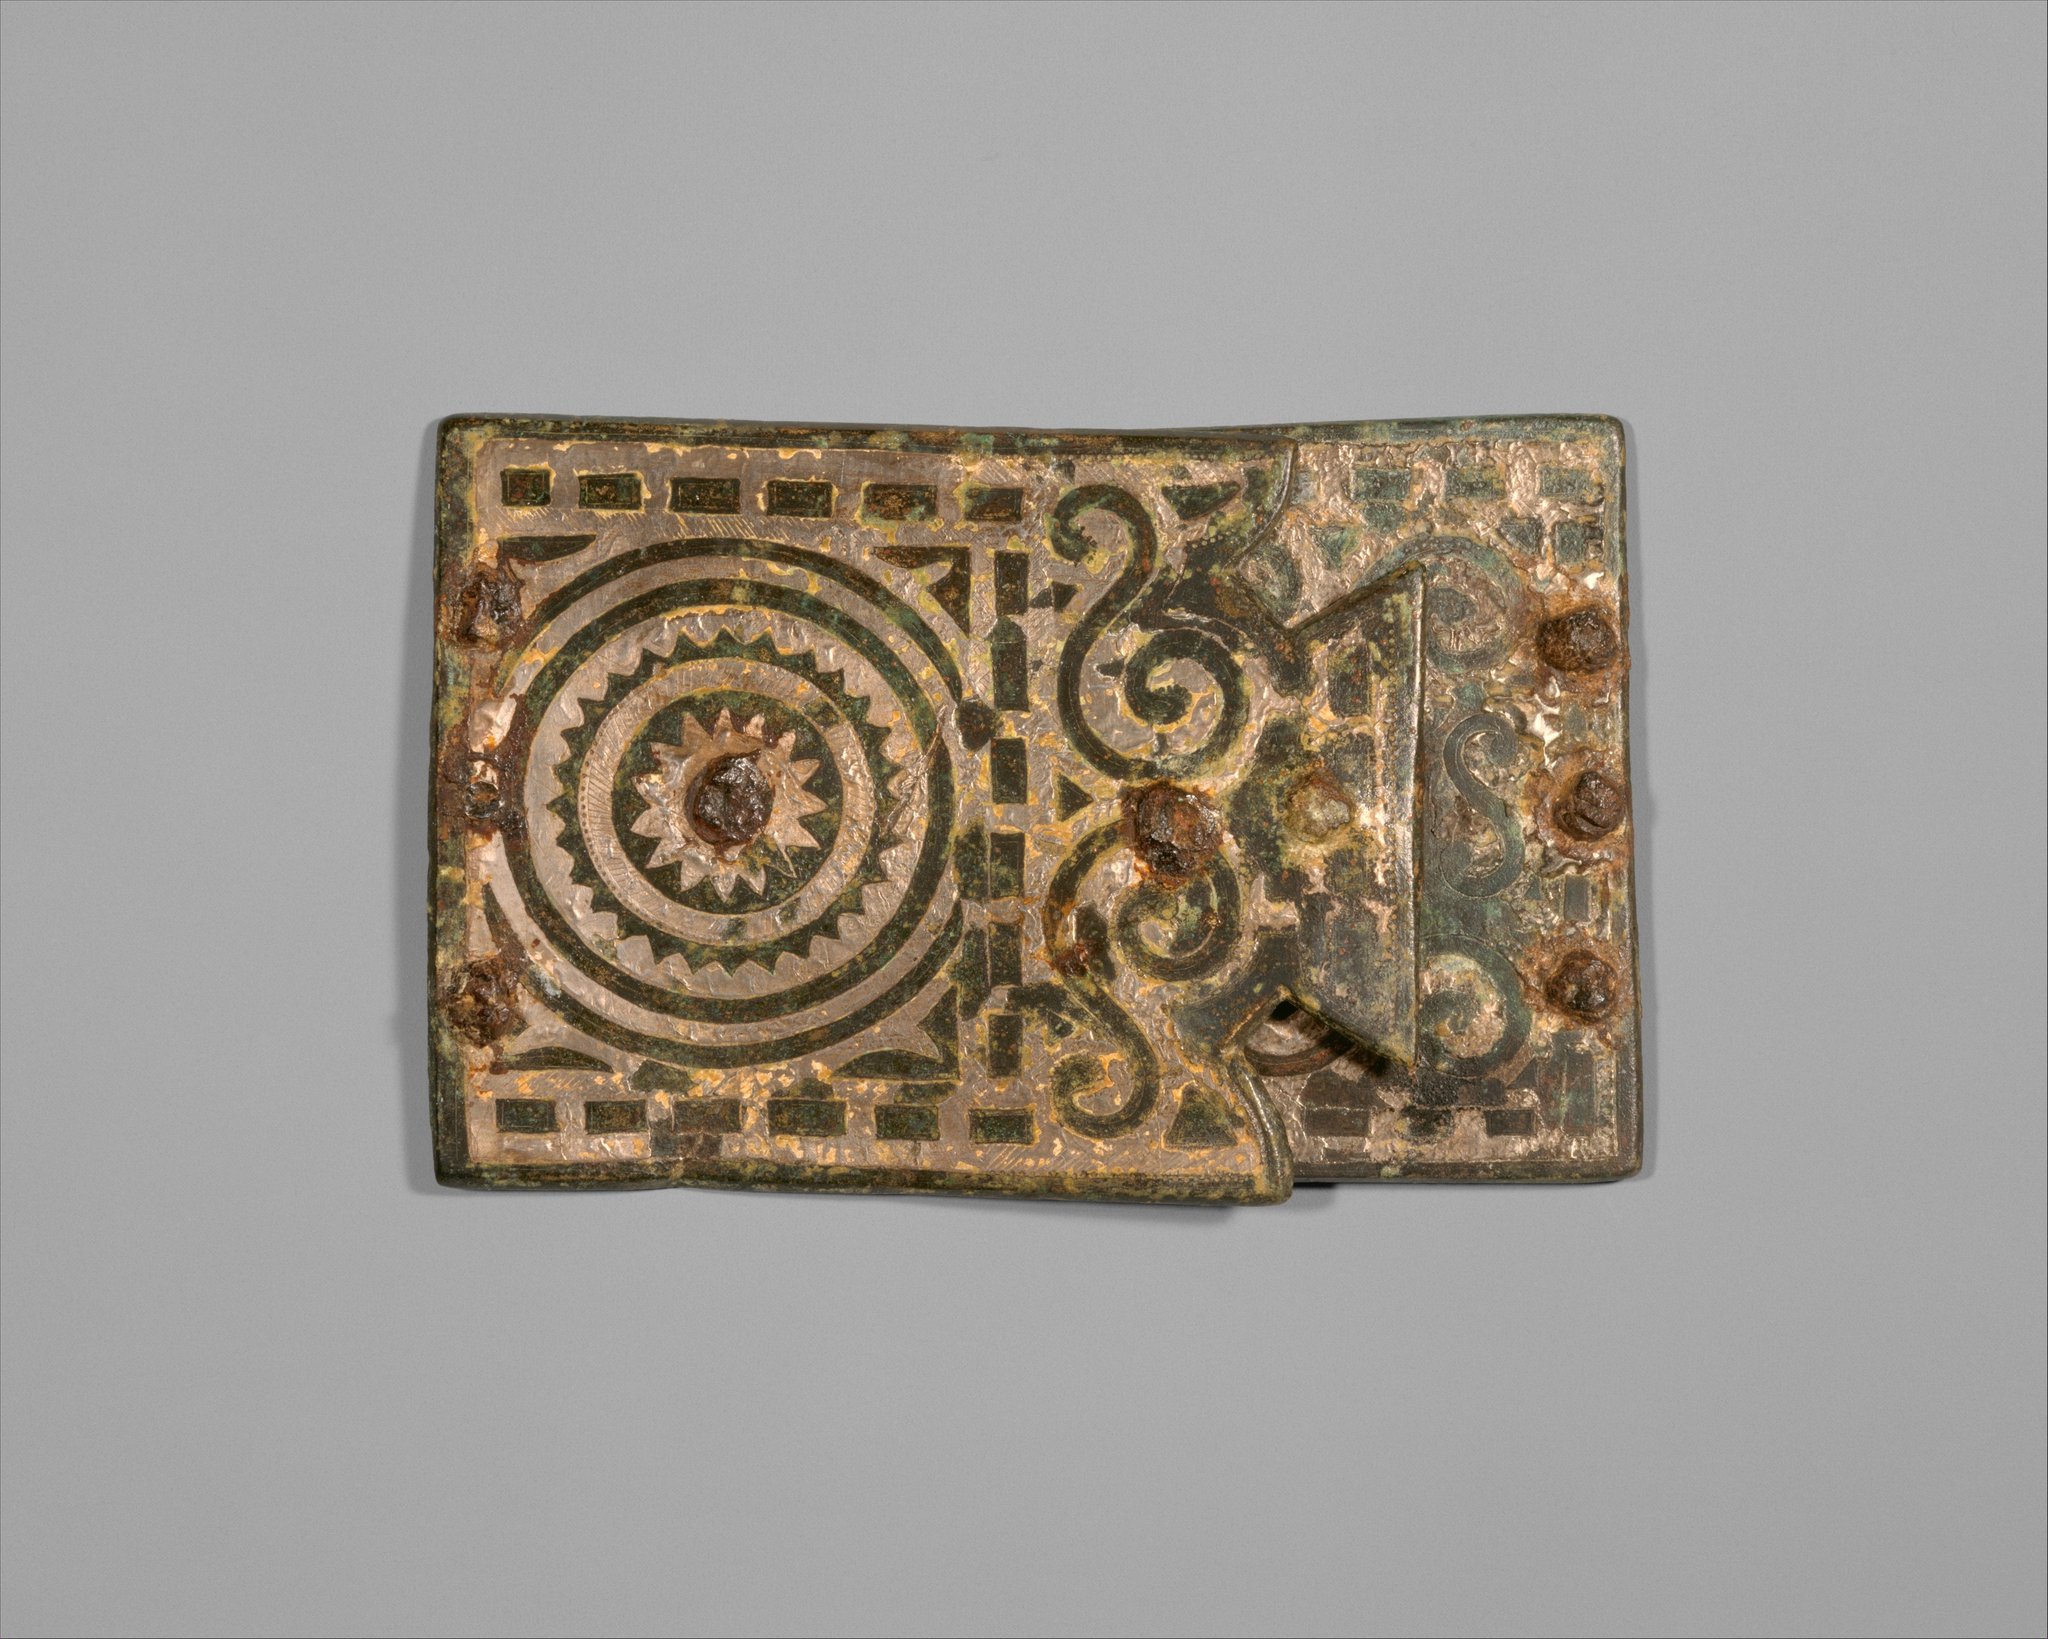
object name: buckle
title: Belt Clasp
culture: celtic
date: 200-101 BCE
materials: bronze, iron, silver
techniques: inlay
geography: spain